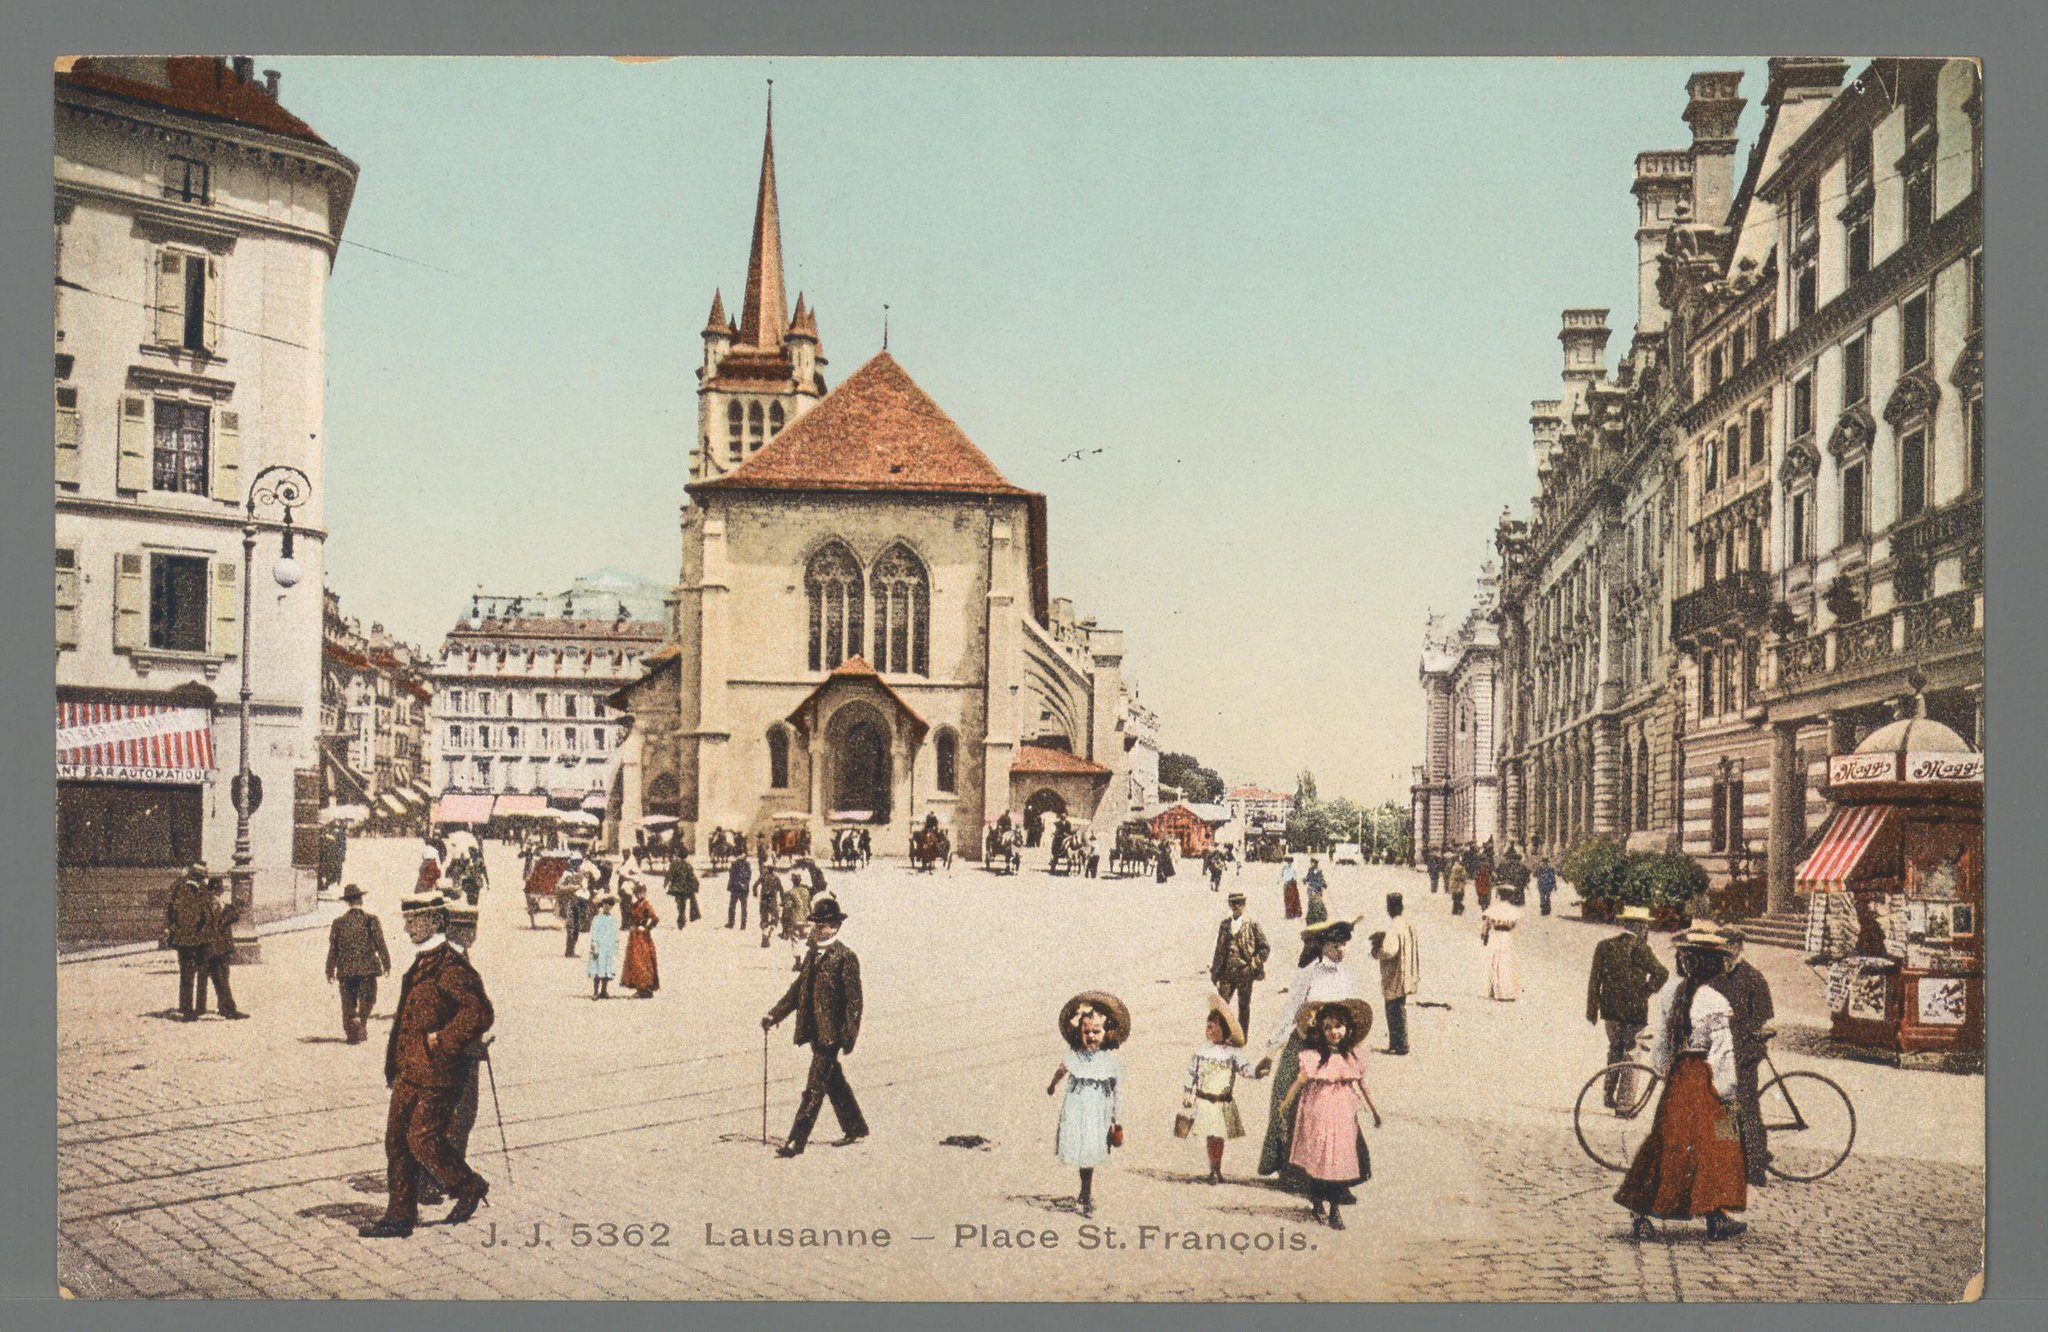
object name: photomechanical print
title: Lausanne. Place St. François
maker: Anonymous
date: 1905-1918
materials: cardboard, photographic process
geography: lausanne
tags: church (exterior), square, place, circus, etc. (+ city(-scape) with figures, staffage)